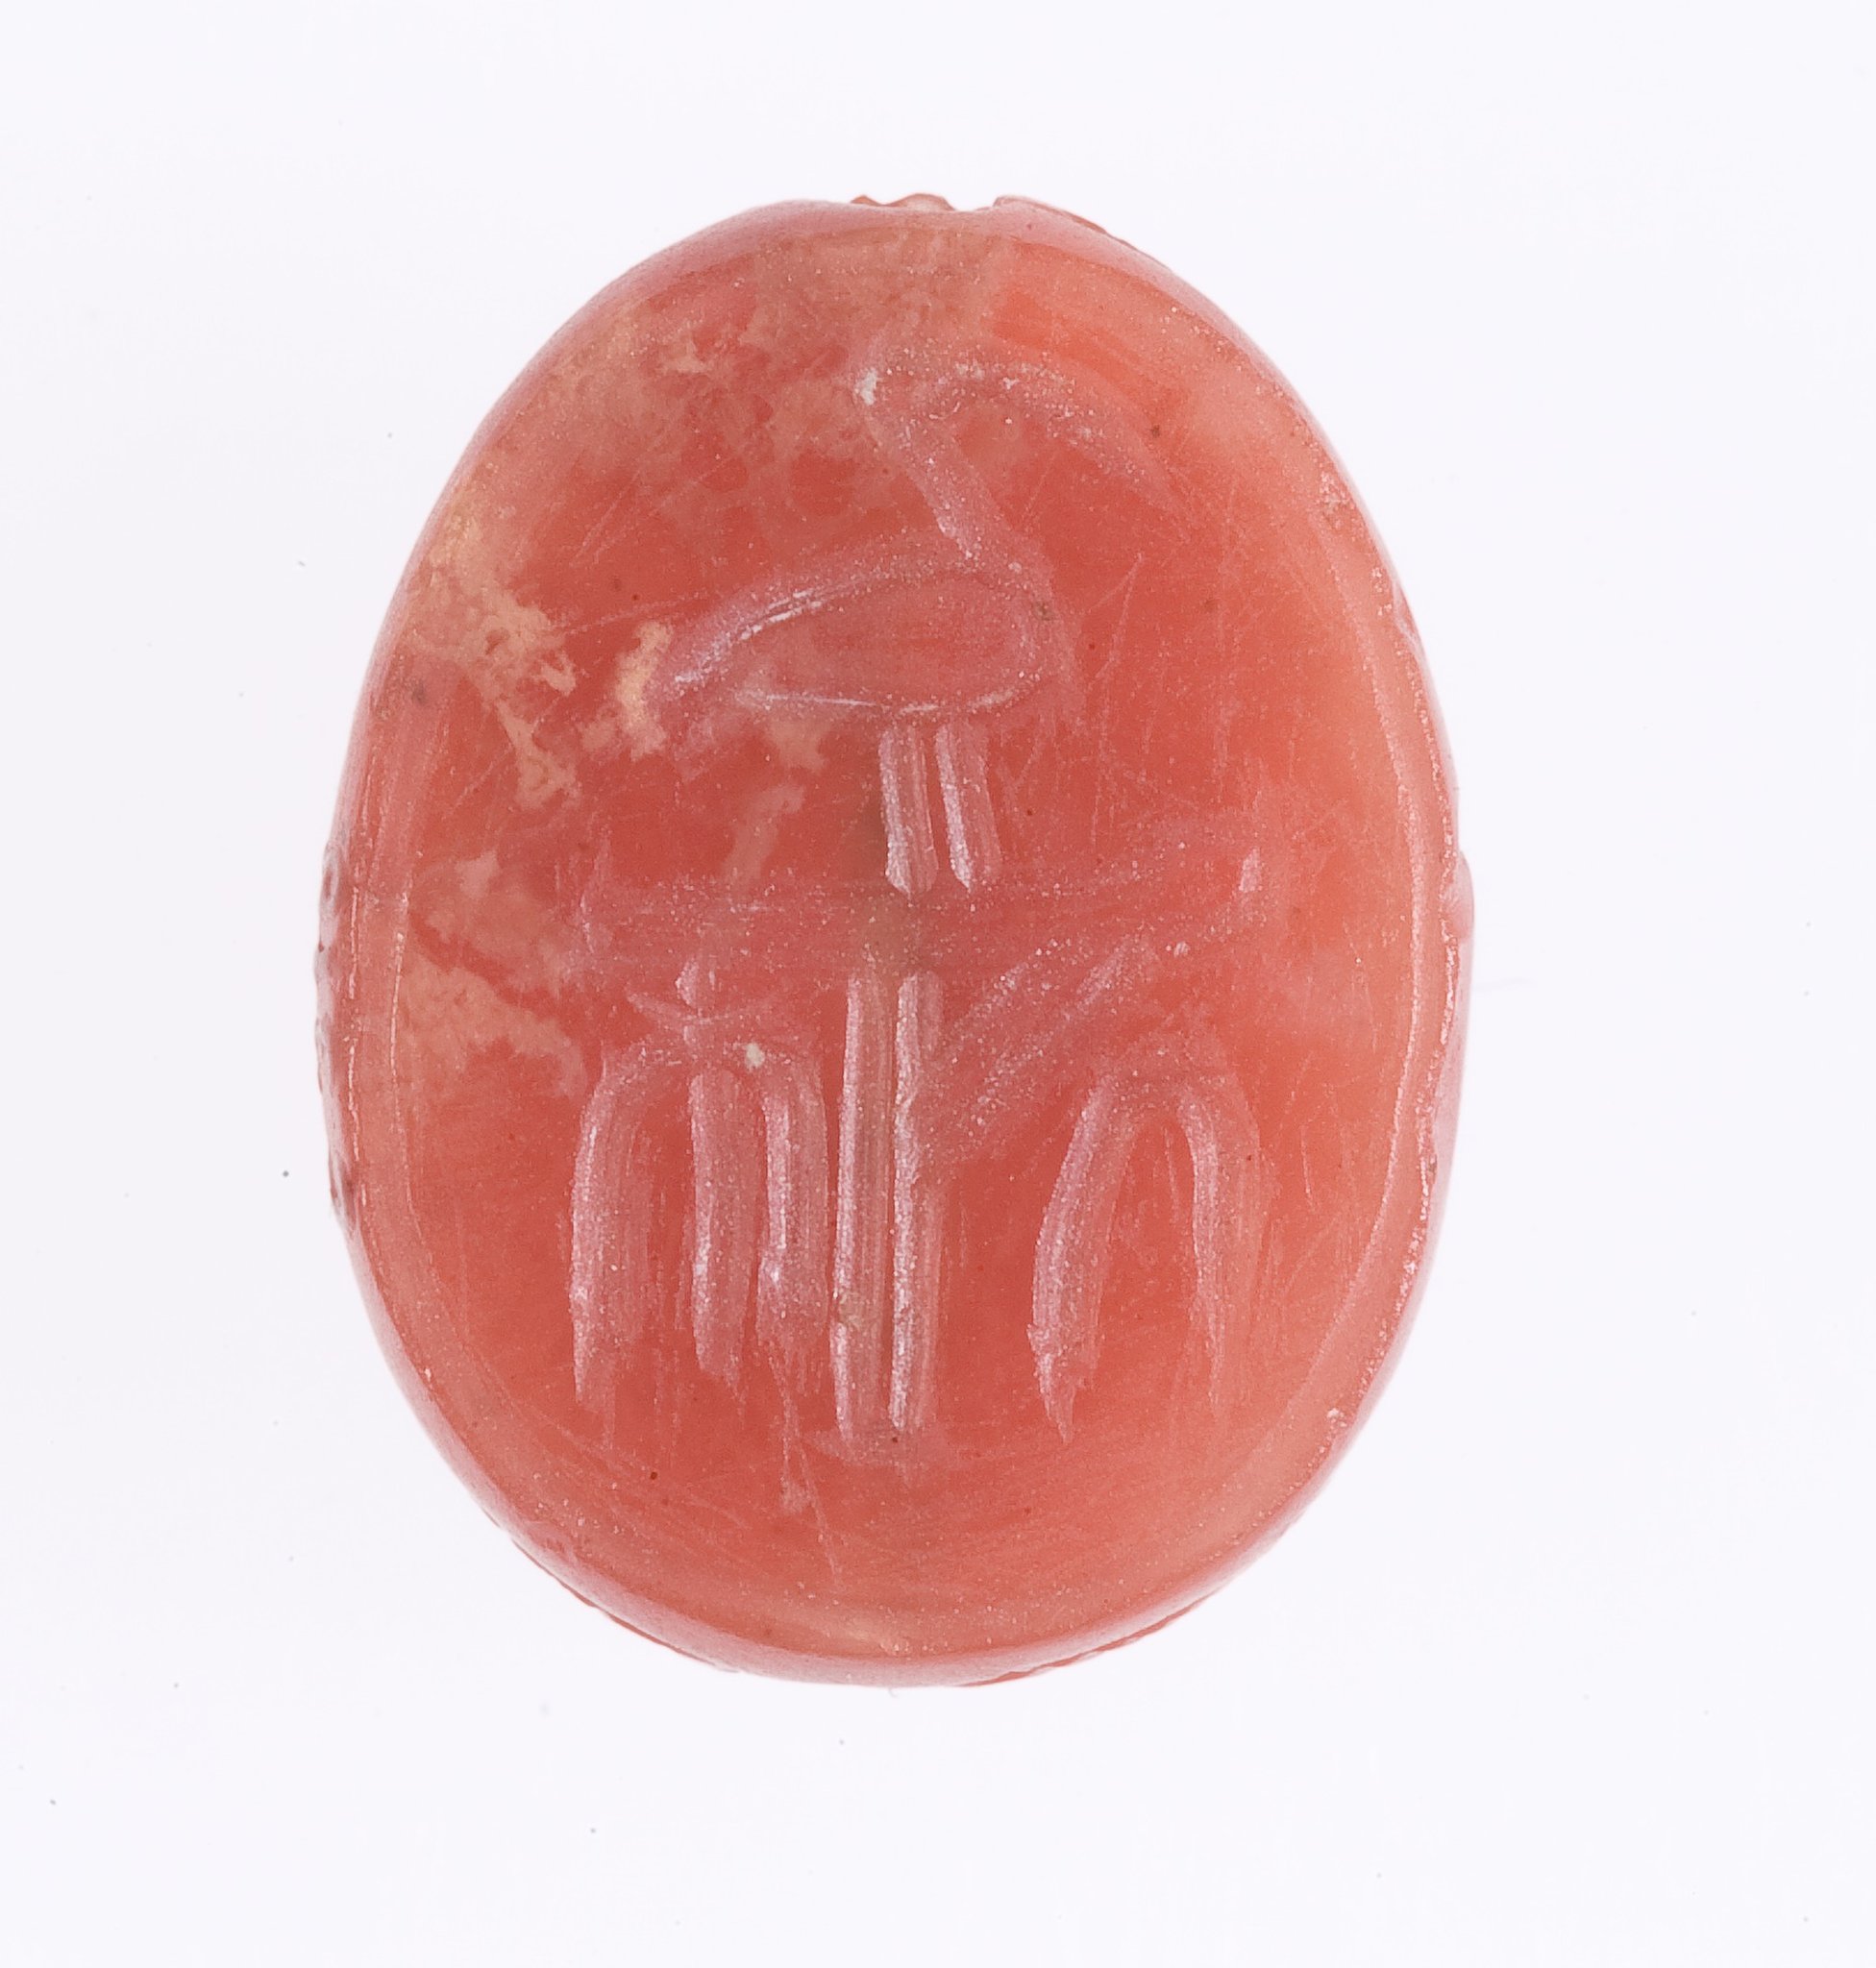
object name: scarab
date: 1635-1458 BCE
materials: gemstone, jasper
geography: egypt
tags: scarabs